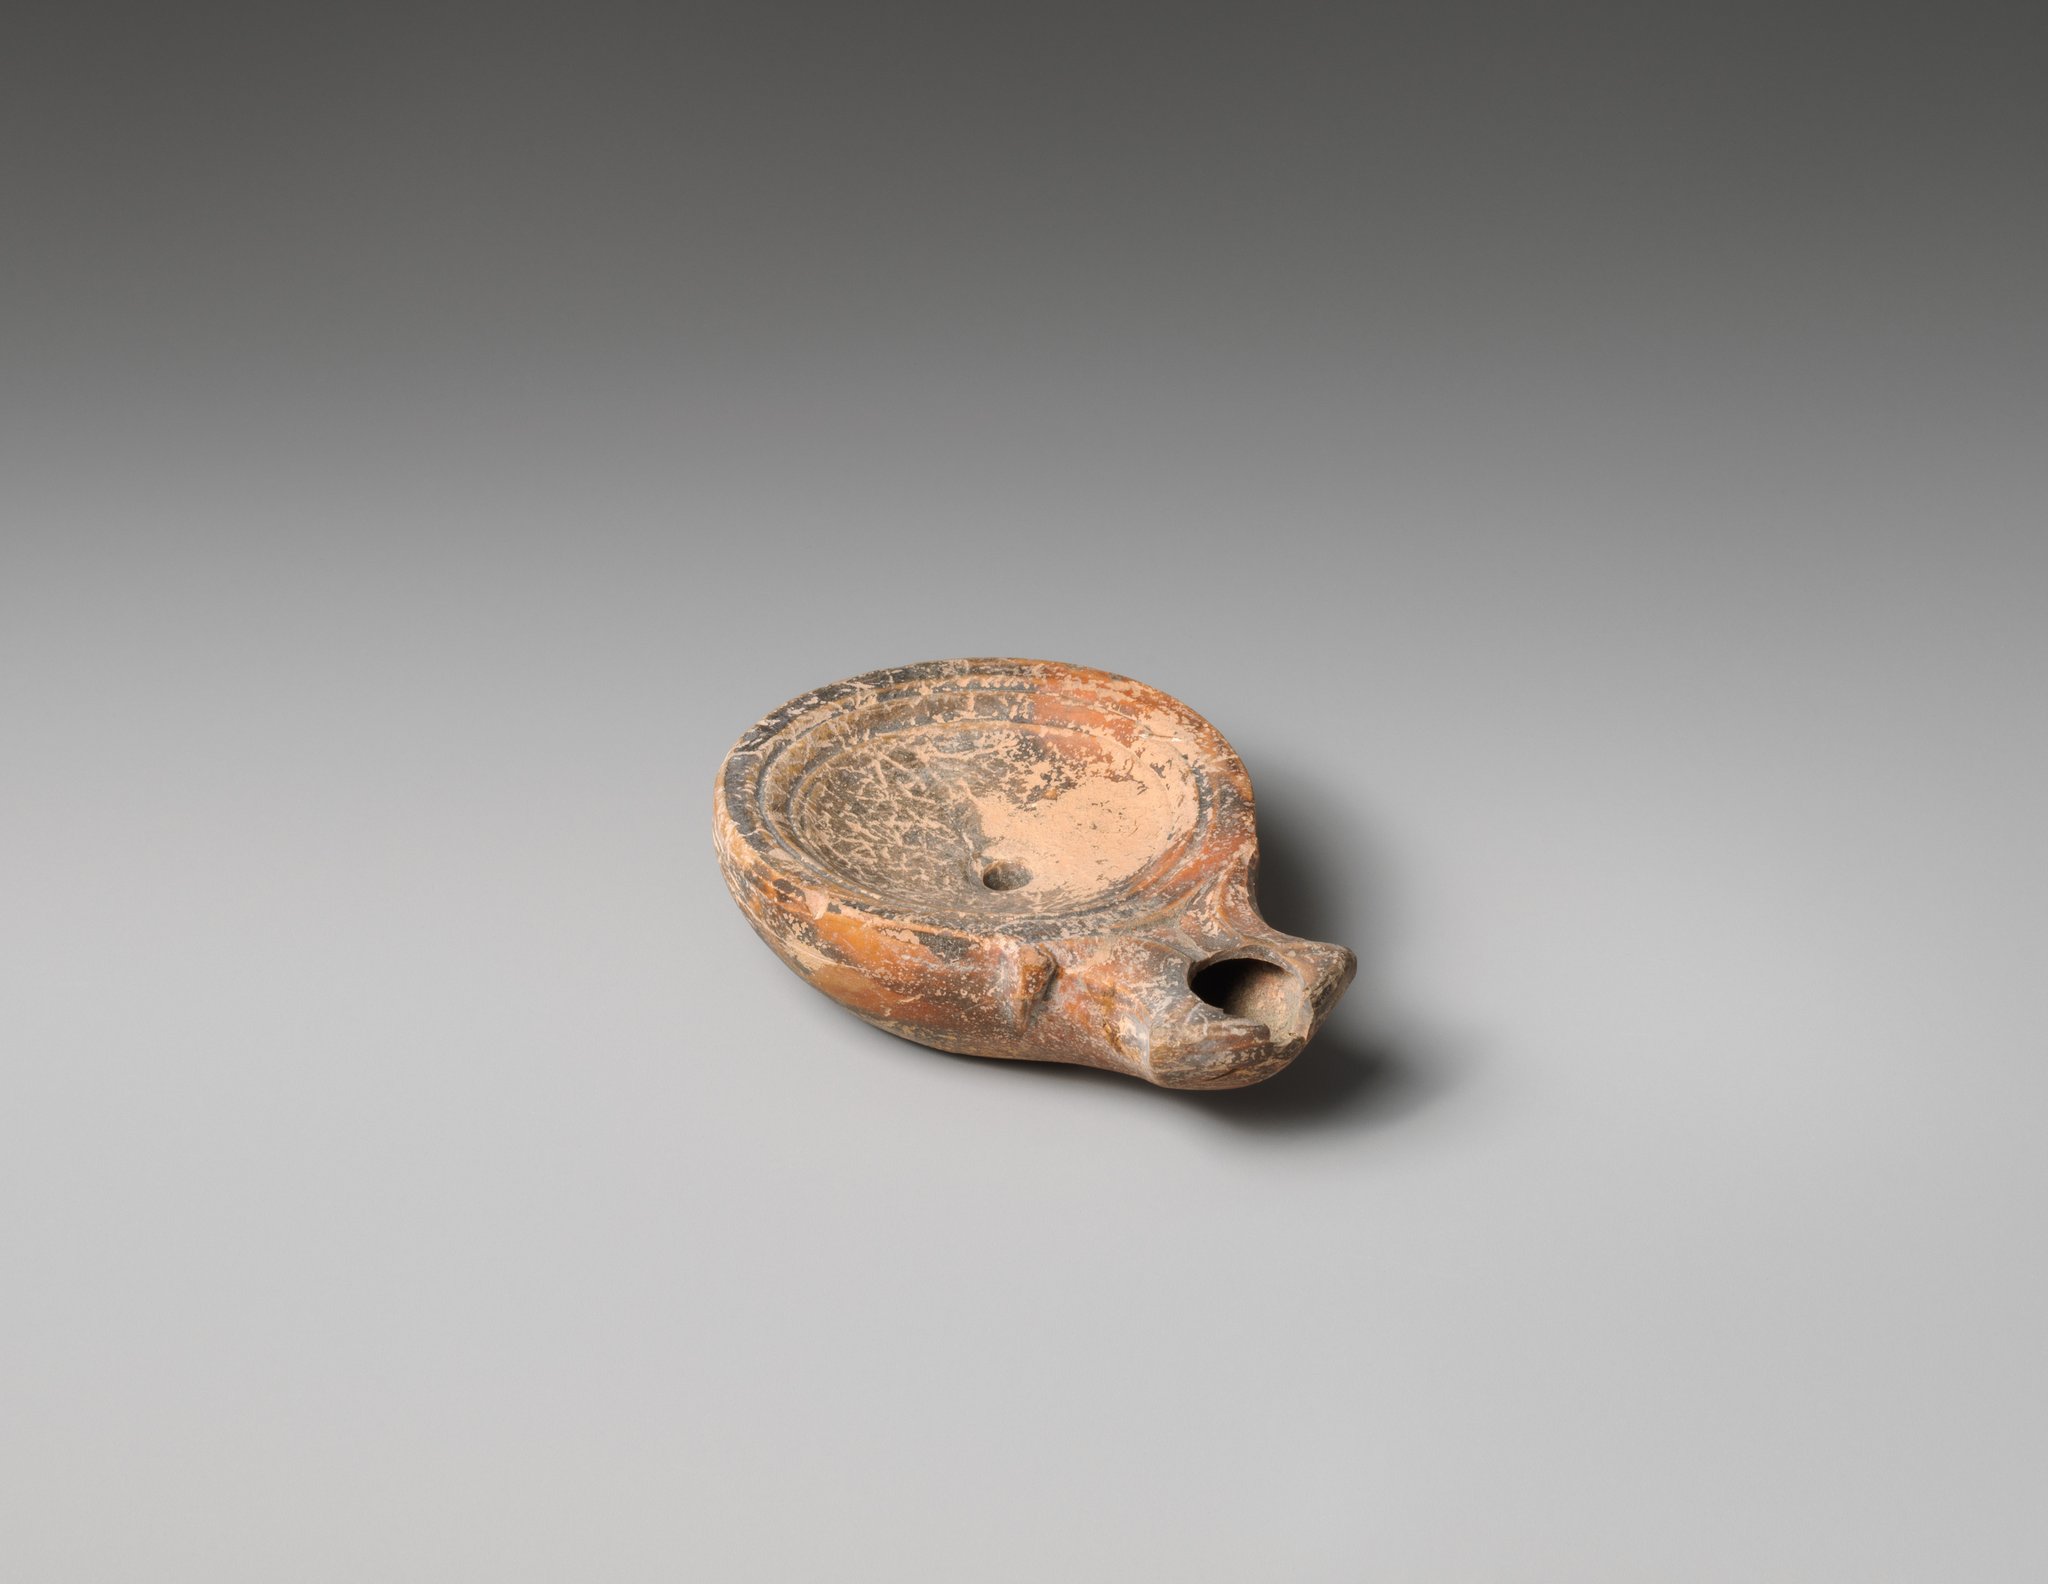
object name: lamp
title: Terracotta oil lamp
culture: roman, cypriot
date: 50-400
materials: terracotta